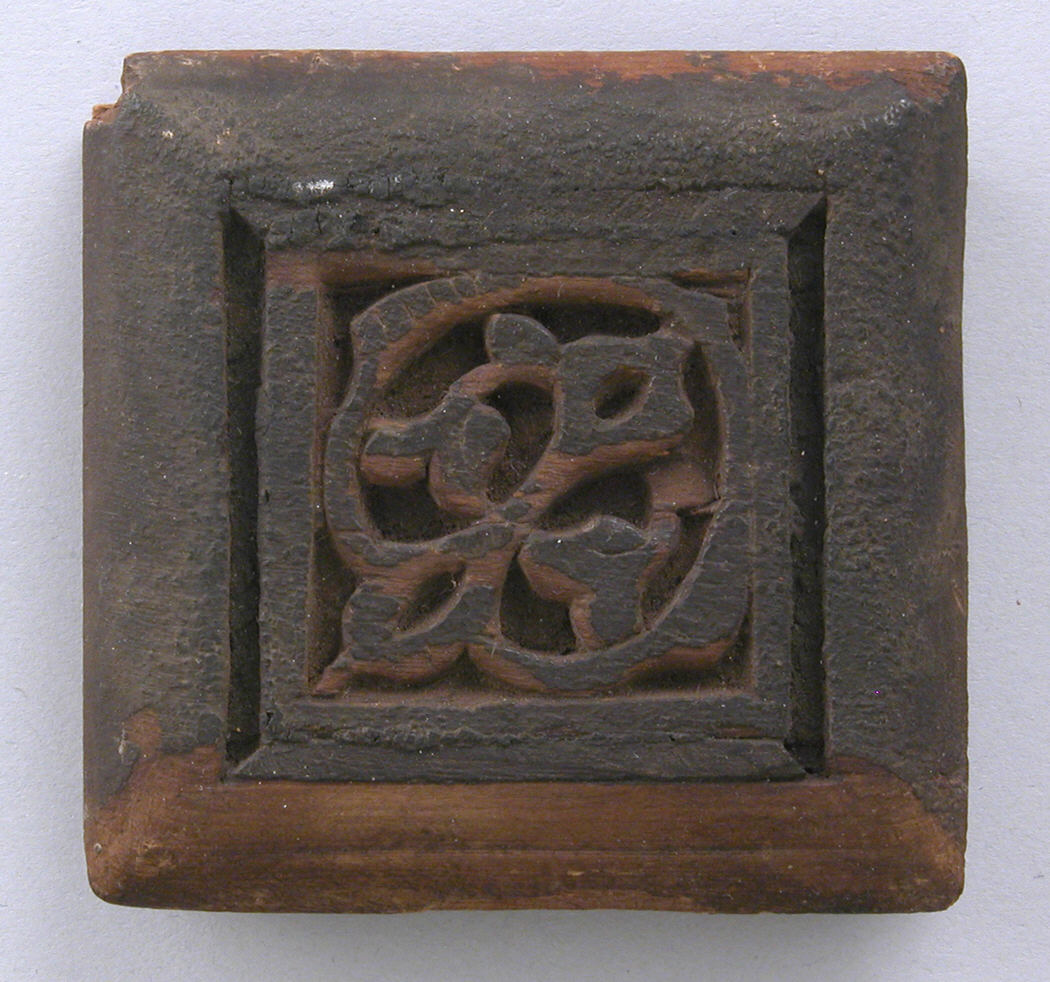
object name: panel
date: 1301-1500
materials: wood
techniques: carving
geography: egypt